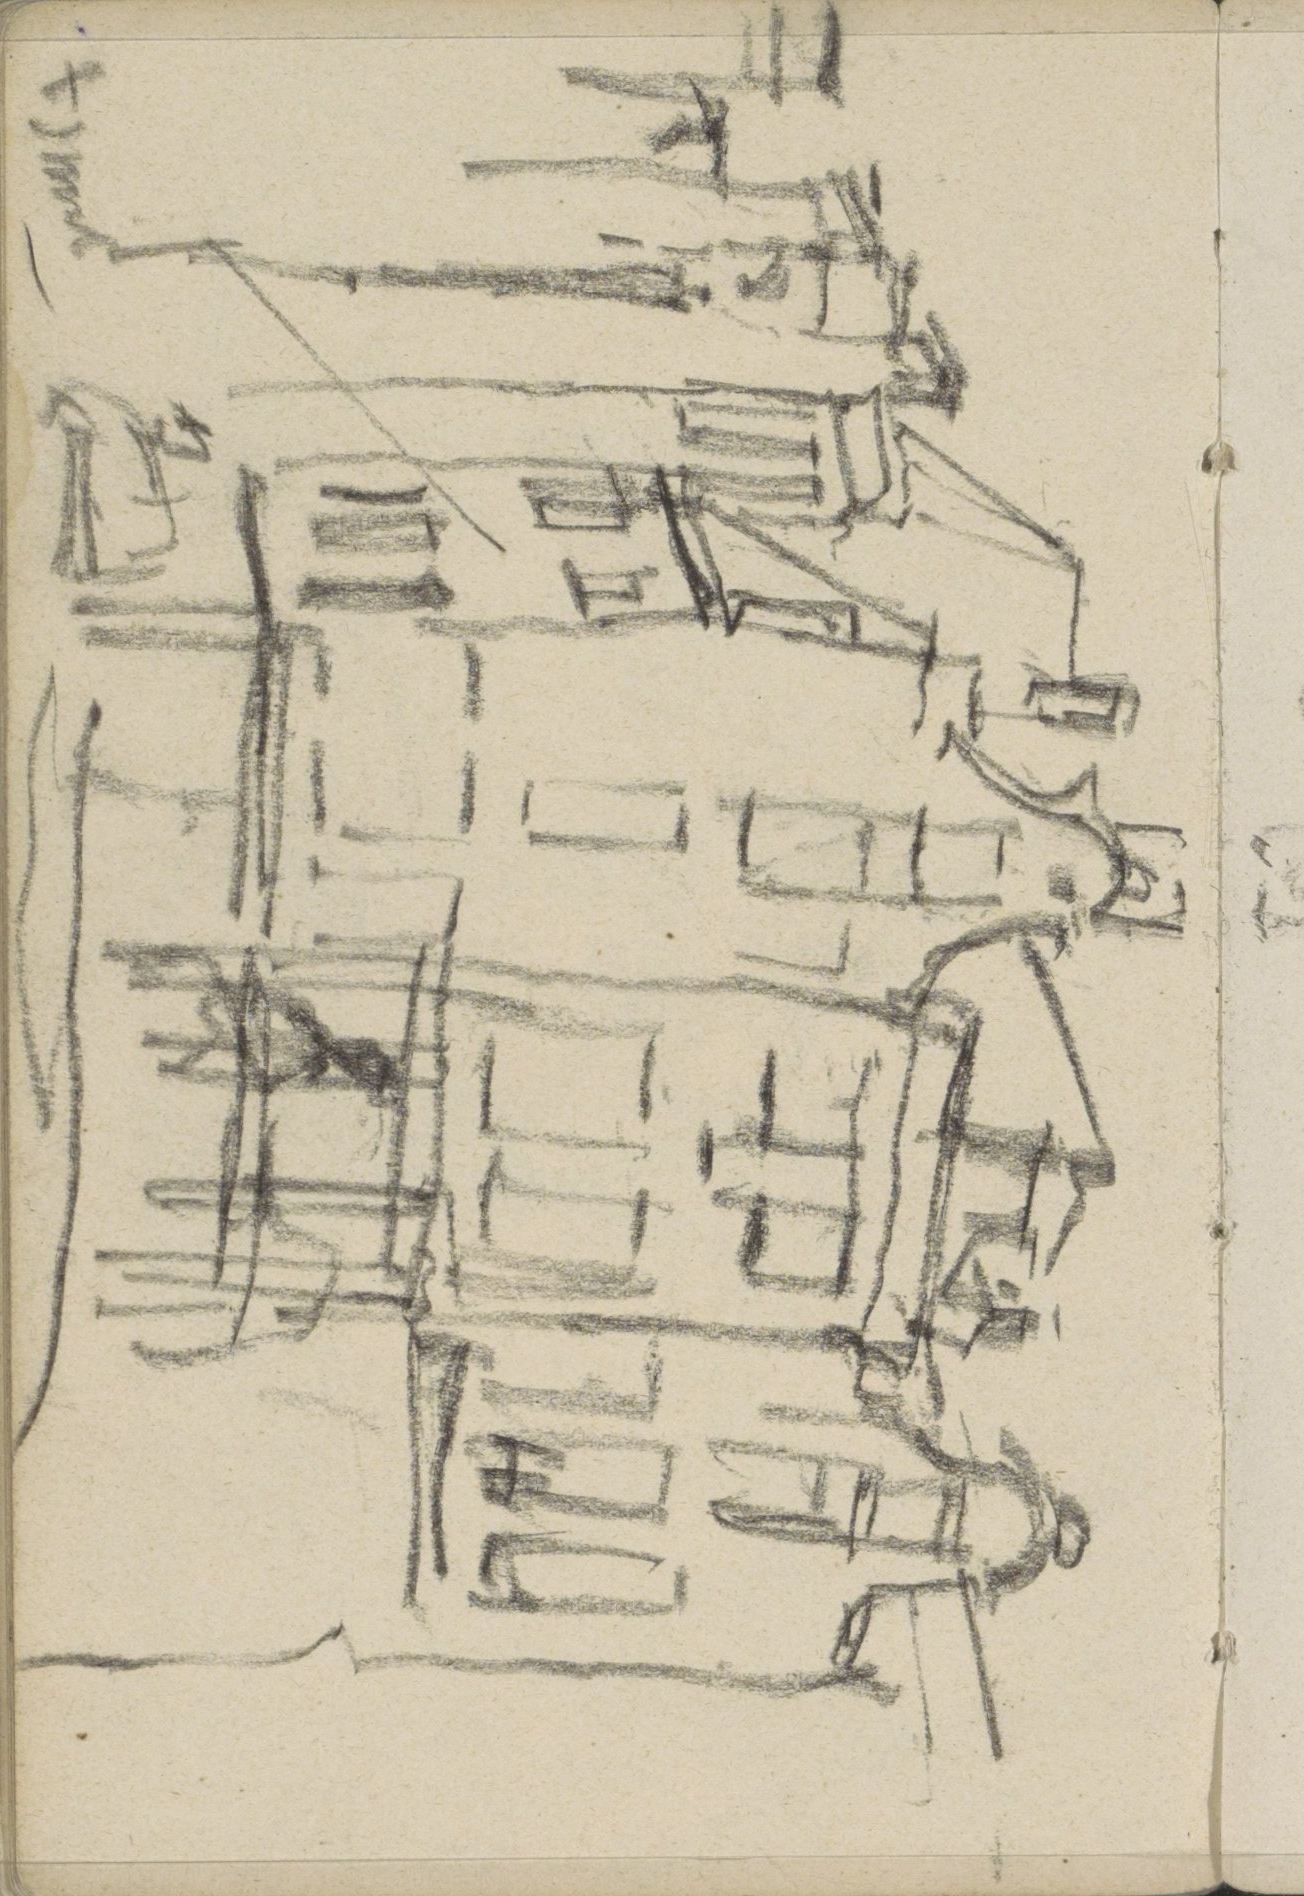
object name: sketchbook leaf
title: Gezicht op gebouwen in Amsterdam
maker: george hendrik breitner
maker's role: draughtsman, painter, print maker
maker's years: 1857-1923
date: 1914-1923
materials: chalk, paper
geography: amsterdam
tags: urban housing, city-view, and landscape with man-made constructions, amsterdam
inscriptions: annotation: ‘t. smit[?]’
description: Gezicht op gebouwen in Amsterdam. Pagina 81 uit een schetsboek met 43 bladen vervaardigd te Amsterdam.